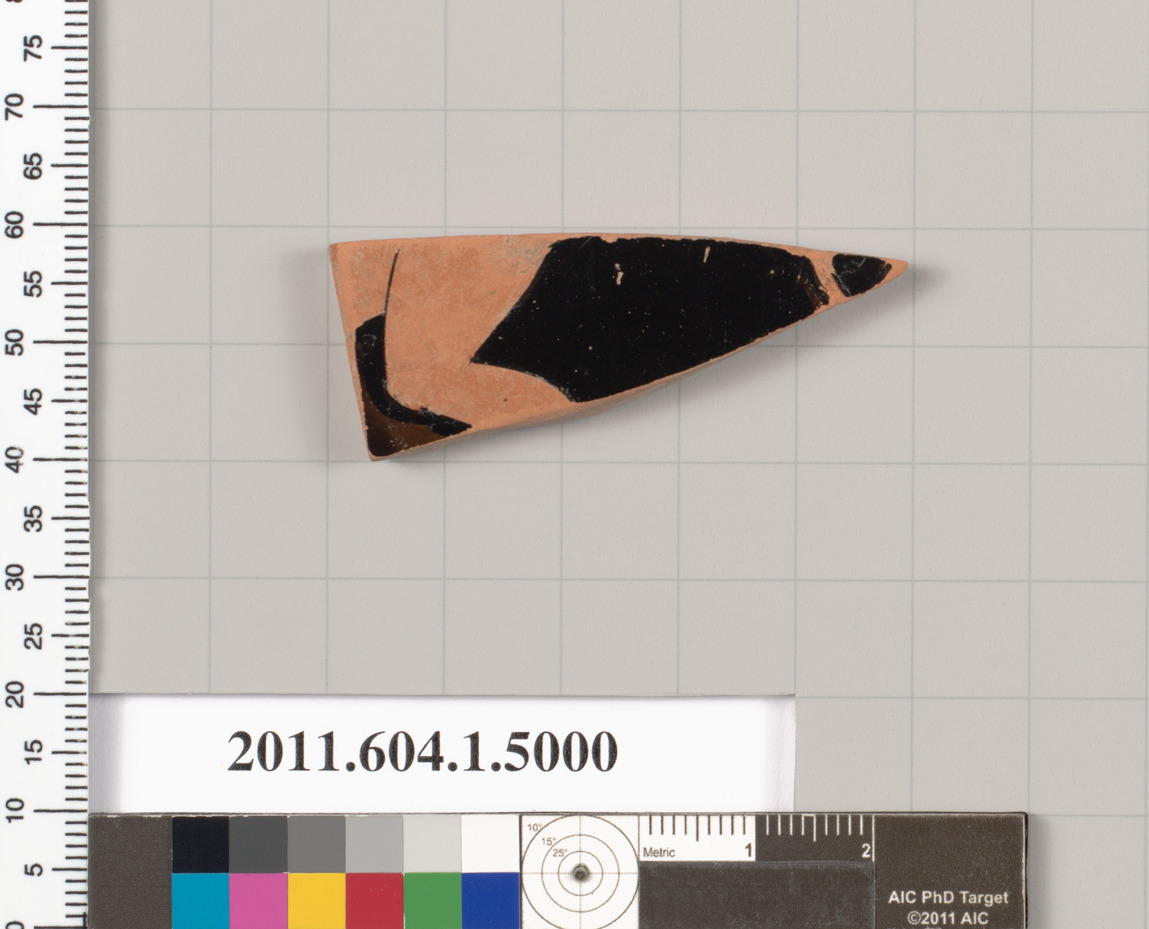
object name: kylix fragment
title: Terracotta fragment of a kylix (drinking cup)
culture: greek, attic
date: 500-480 BCE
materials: terracotta